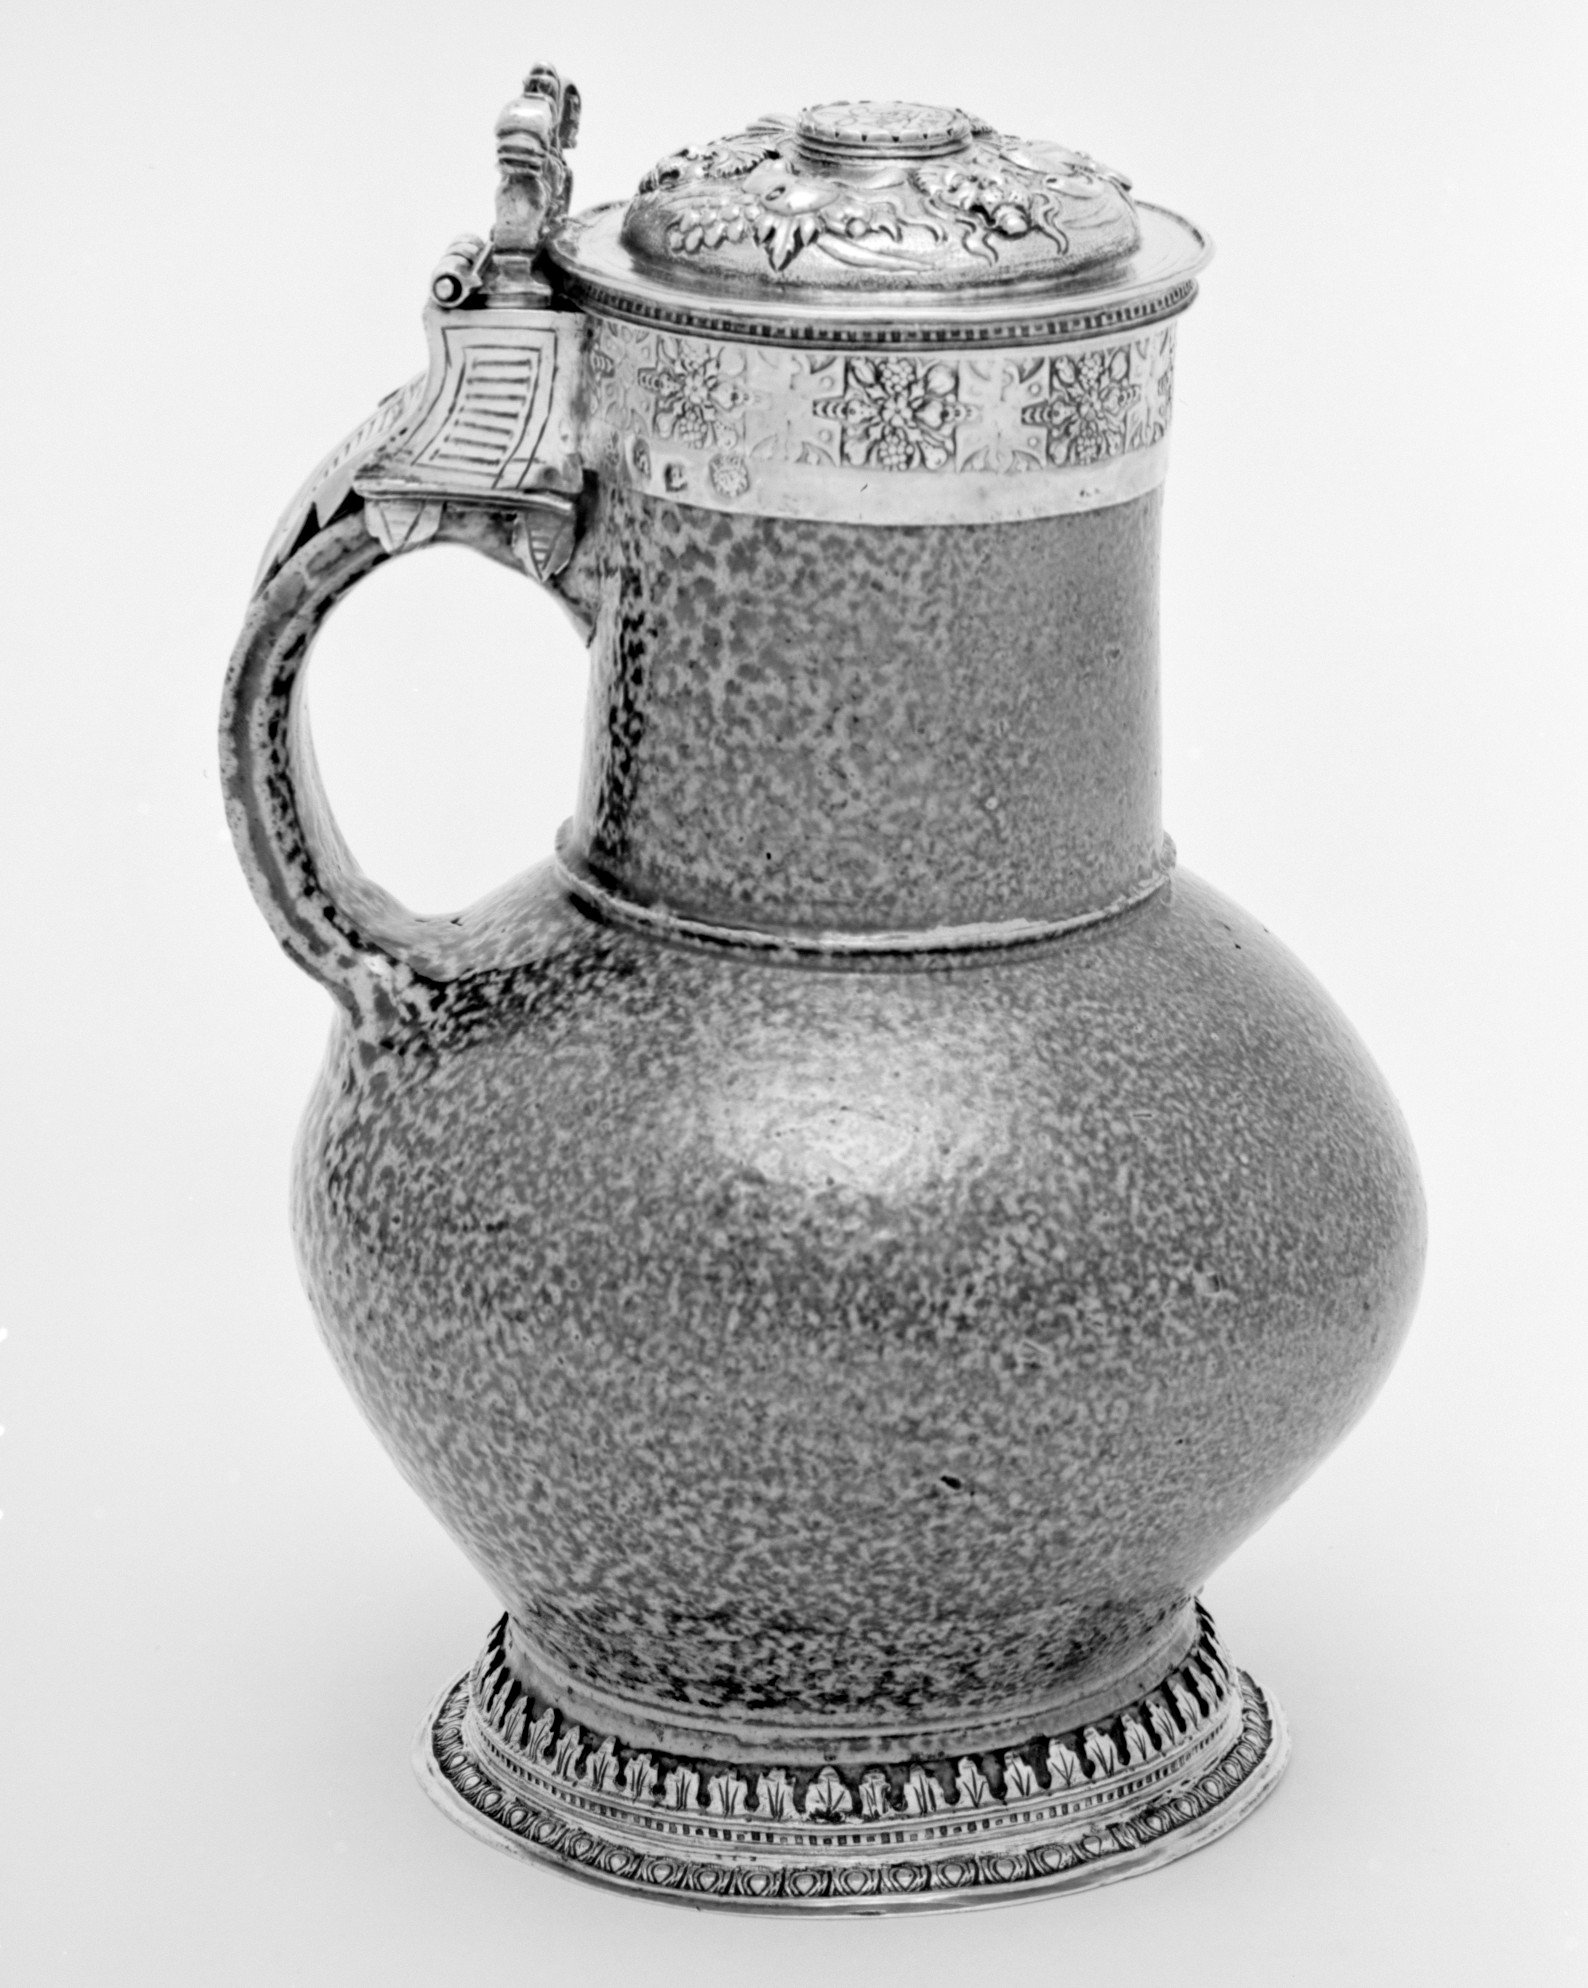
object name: jug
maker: john harryson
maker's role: maker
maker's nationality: british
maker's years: 1570-1586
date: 1555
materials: silver gilt